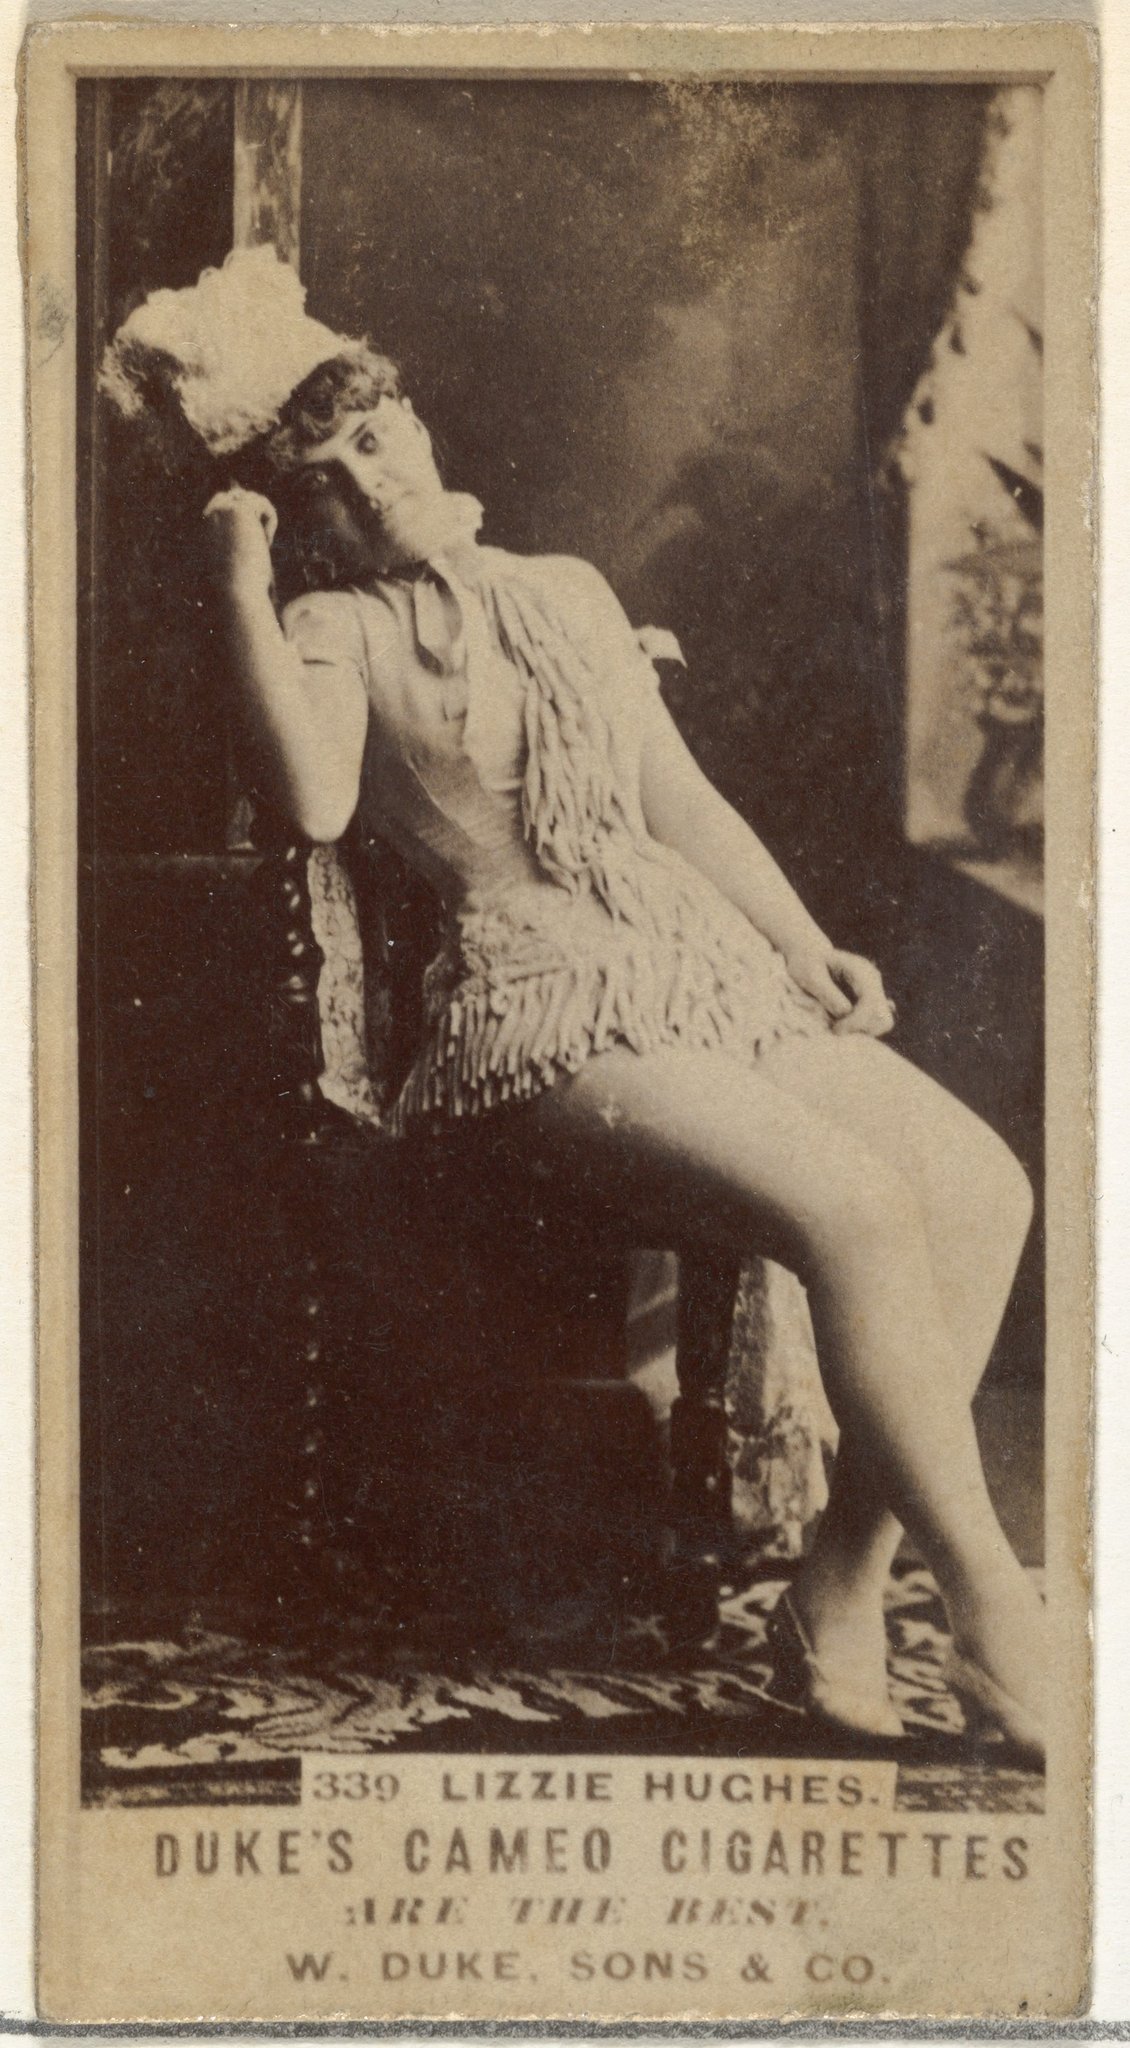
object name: photograph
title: Card Number 330, Lizzie Hughes, from the Actors and Actresses series (N145-5) issued by Duke Sons & Co. to promote Cameo Cigarettes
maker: w. duke, sons & co.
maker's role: publisher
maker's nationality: american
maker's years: 1870-1920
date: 1880-1889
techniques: albumen silver print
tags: portraits,women,actresses